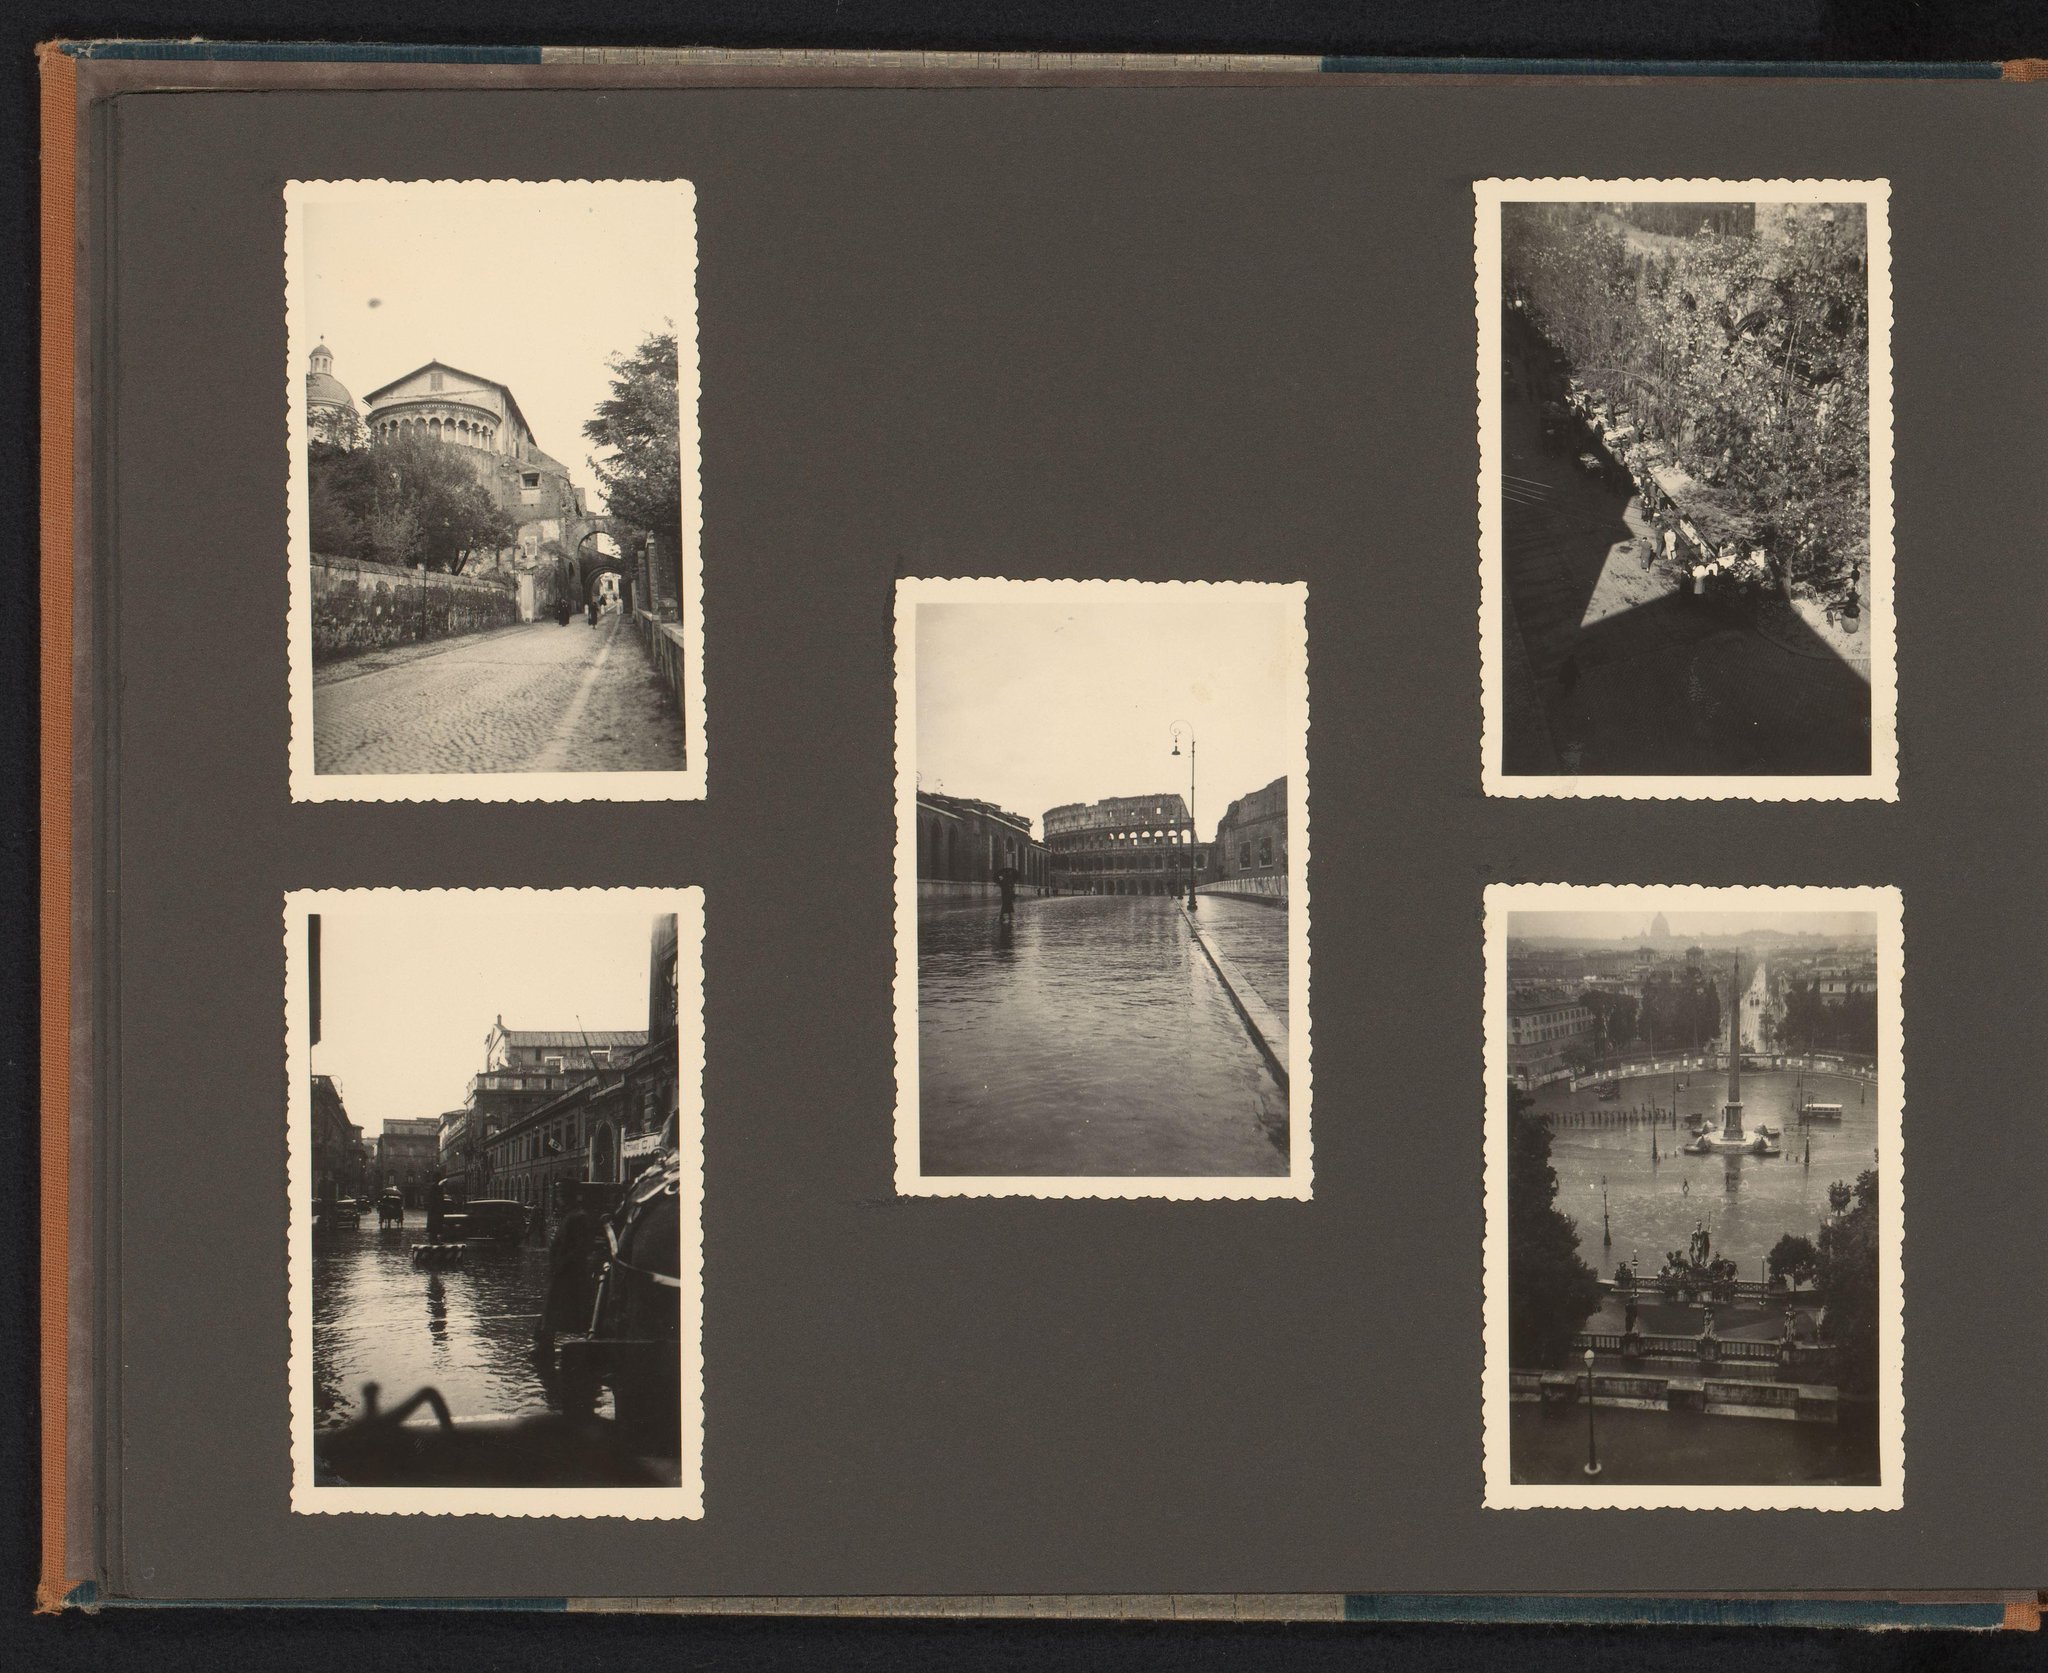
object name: photograph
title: Straatgezichten te Rome, met het Colosseum en Piazza del Popolo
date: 1936-1939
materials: cardboard, paper, photographic support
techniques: gelatin silver print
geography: rome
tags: square, place, circus, etc., church (exterior), street (+ city(-scape) with figures, staffage)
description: Vijf foto's gemaakt tijdens de vakantie van Berti Hoppe en Herman Besselaar naar Rome. Deze pagina maakt deel uit van een album.